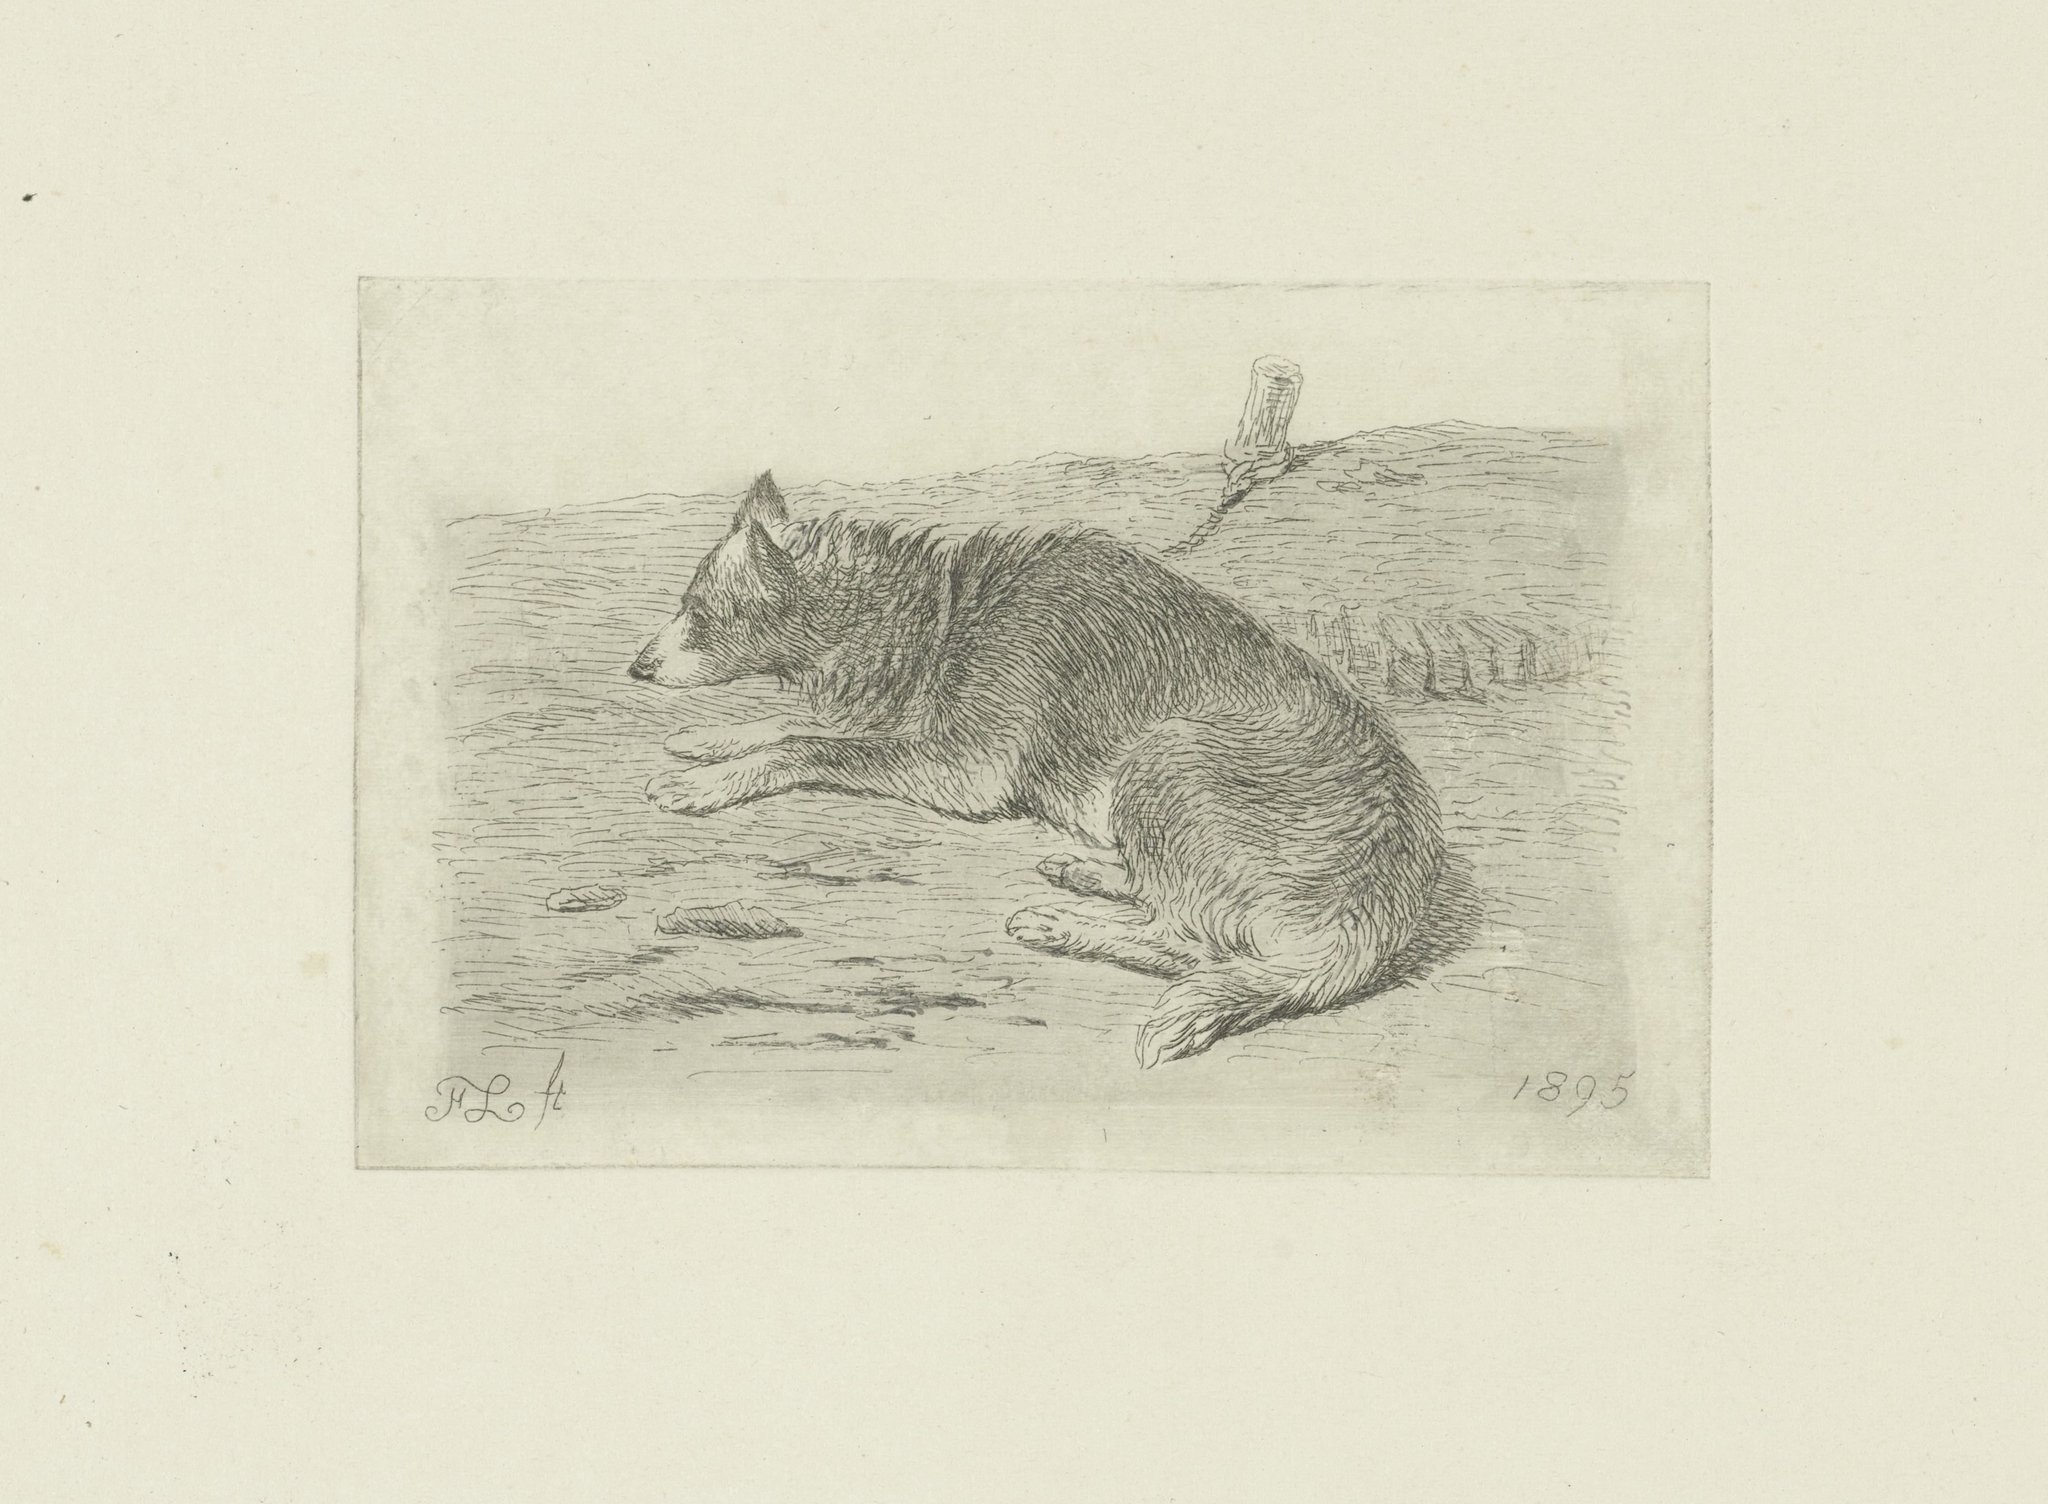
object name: print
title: Hond in diverse houdingen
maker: frans lebret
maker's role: draughtsman, painter, print maker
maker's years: 1820-1909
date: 1895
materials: paper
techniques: etching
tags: dog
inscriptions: collector's mark: Lugt 2228, number: ‘6’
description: Een liggende hond met neerhangende kop. Aan zijn halsband is een touw bevestigd dat om een paaltje is gelegd. De prent maakt deel uit van een zesdelige serie met prenten van dezelfde hond in verschillende houdingen.